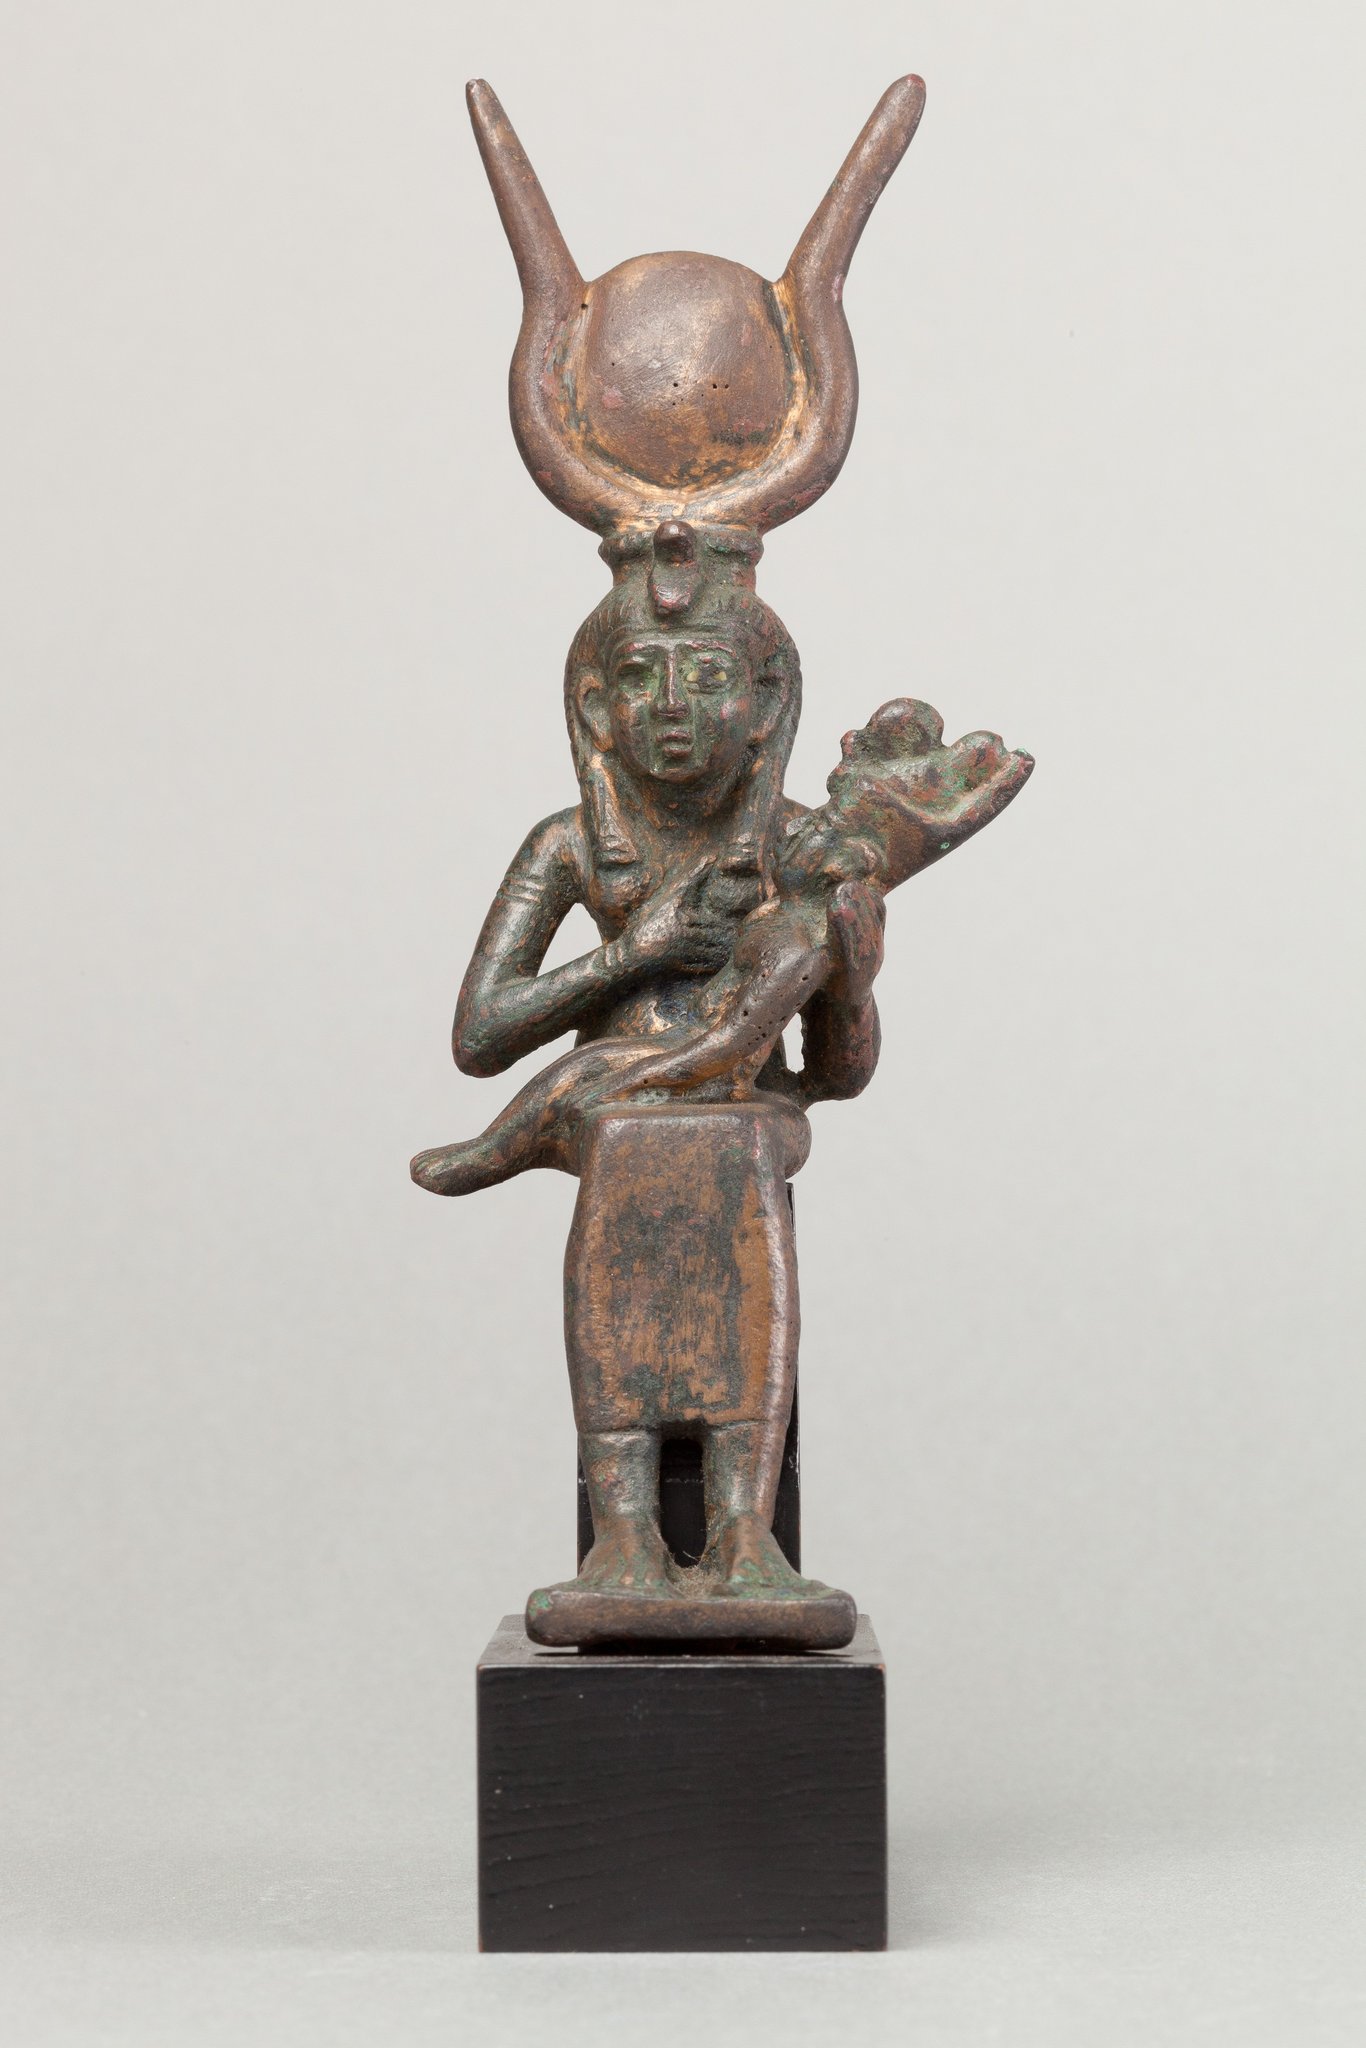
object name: statuette, isi, horus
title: Isis and Horus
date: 664-630 BCE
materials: metal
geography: egypt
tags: horus,isis,nursing